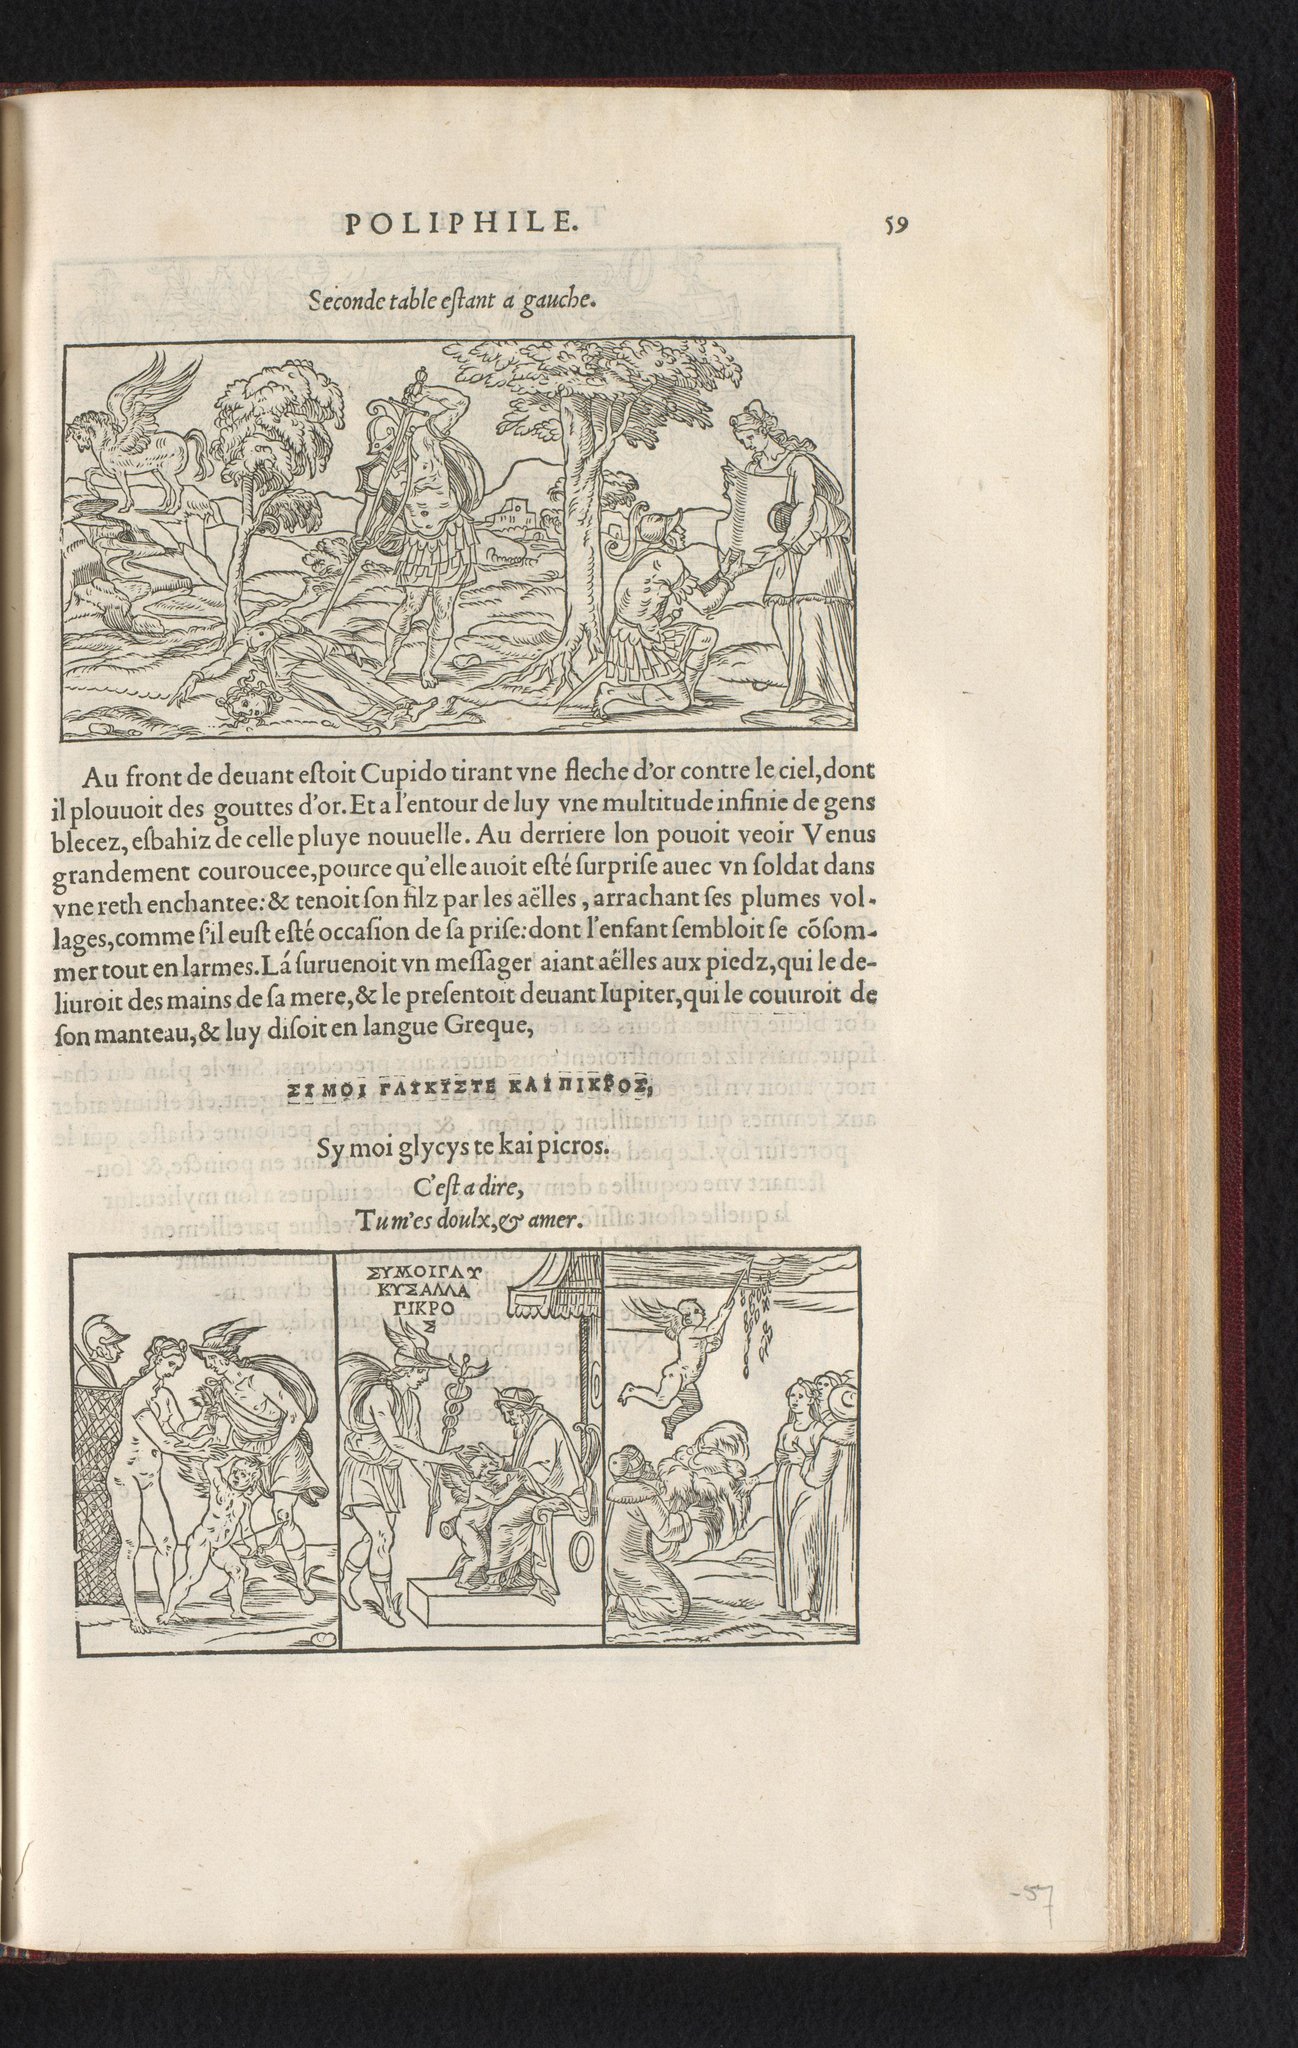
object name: print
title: Perseus en Medusa en drie scènes met Cupido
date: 1546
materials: paper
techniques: letterpress printing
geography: paris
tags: pegasus, the winged horse, (scenes from) specific works of literature: colonna, hypnerotomachia poliphili, minerva gives perseus the shield (or mirror), perseus beheading medusa, with pegasus, and possibly also chrysaor, the warrior with the golden sword, springing from the blood of medusa's head, venus and cupid (cupid not being mere attribute)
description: Boven: Perseus ontvangt het schild van Minerva en doodt Medusa, met geheel links Pegasus, geboren uit het bloed van Medusa. Onder: Venus en Cupido, Mercurius en Cupido bij een koning, en Cupido trekt een gouden pijl uit een wolk. Prent maakt deel uit van een boek.